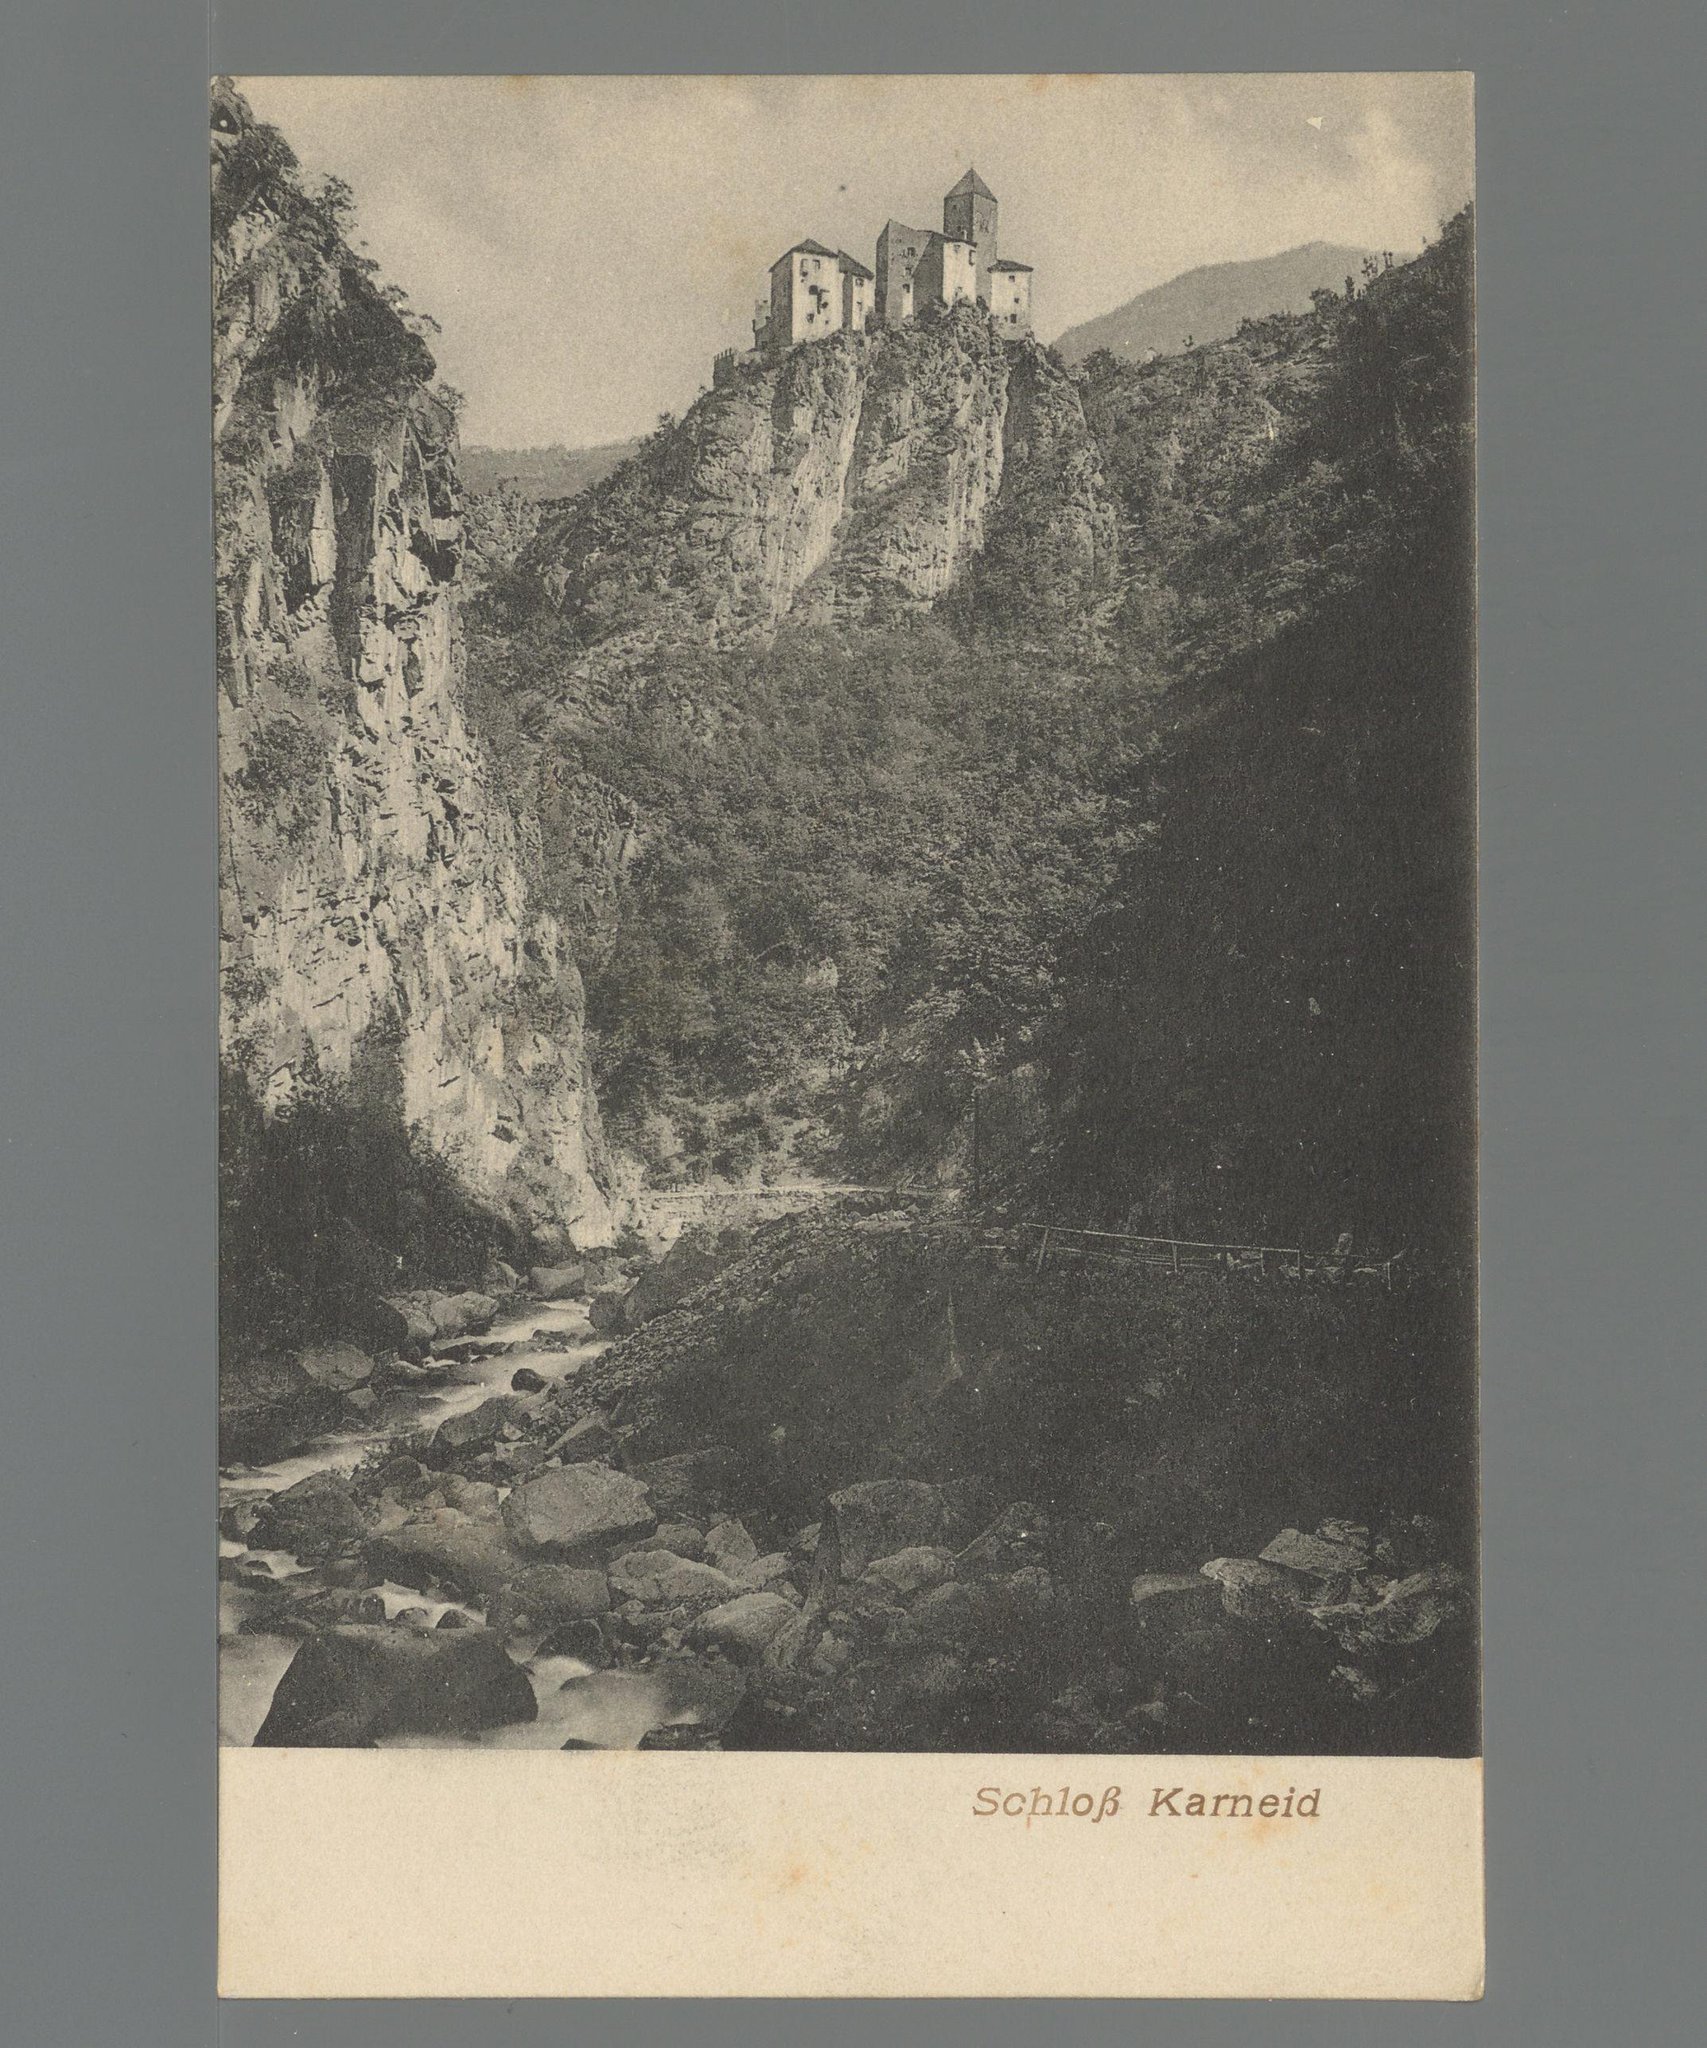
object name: photomechanical print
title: Schloβ Karneid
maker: Anonymous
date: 1906-1907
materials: cardboard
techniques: photograph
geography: karneid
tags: castle, mountains